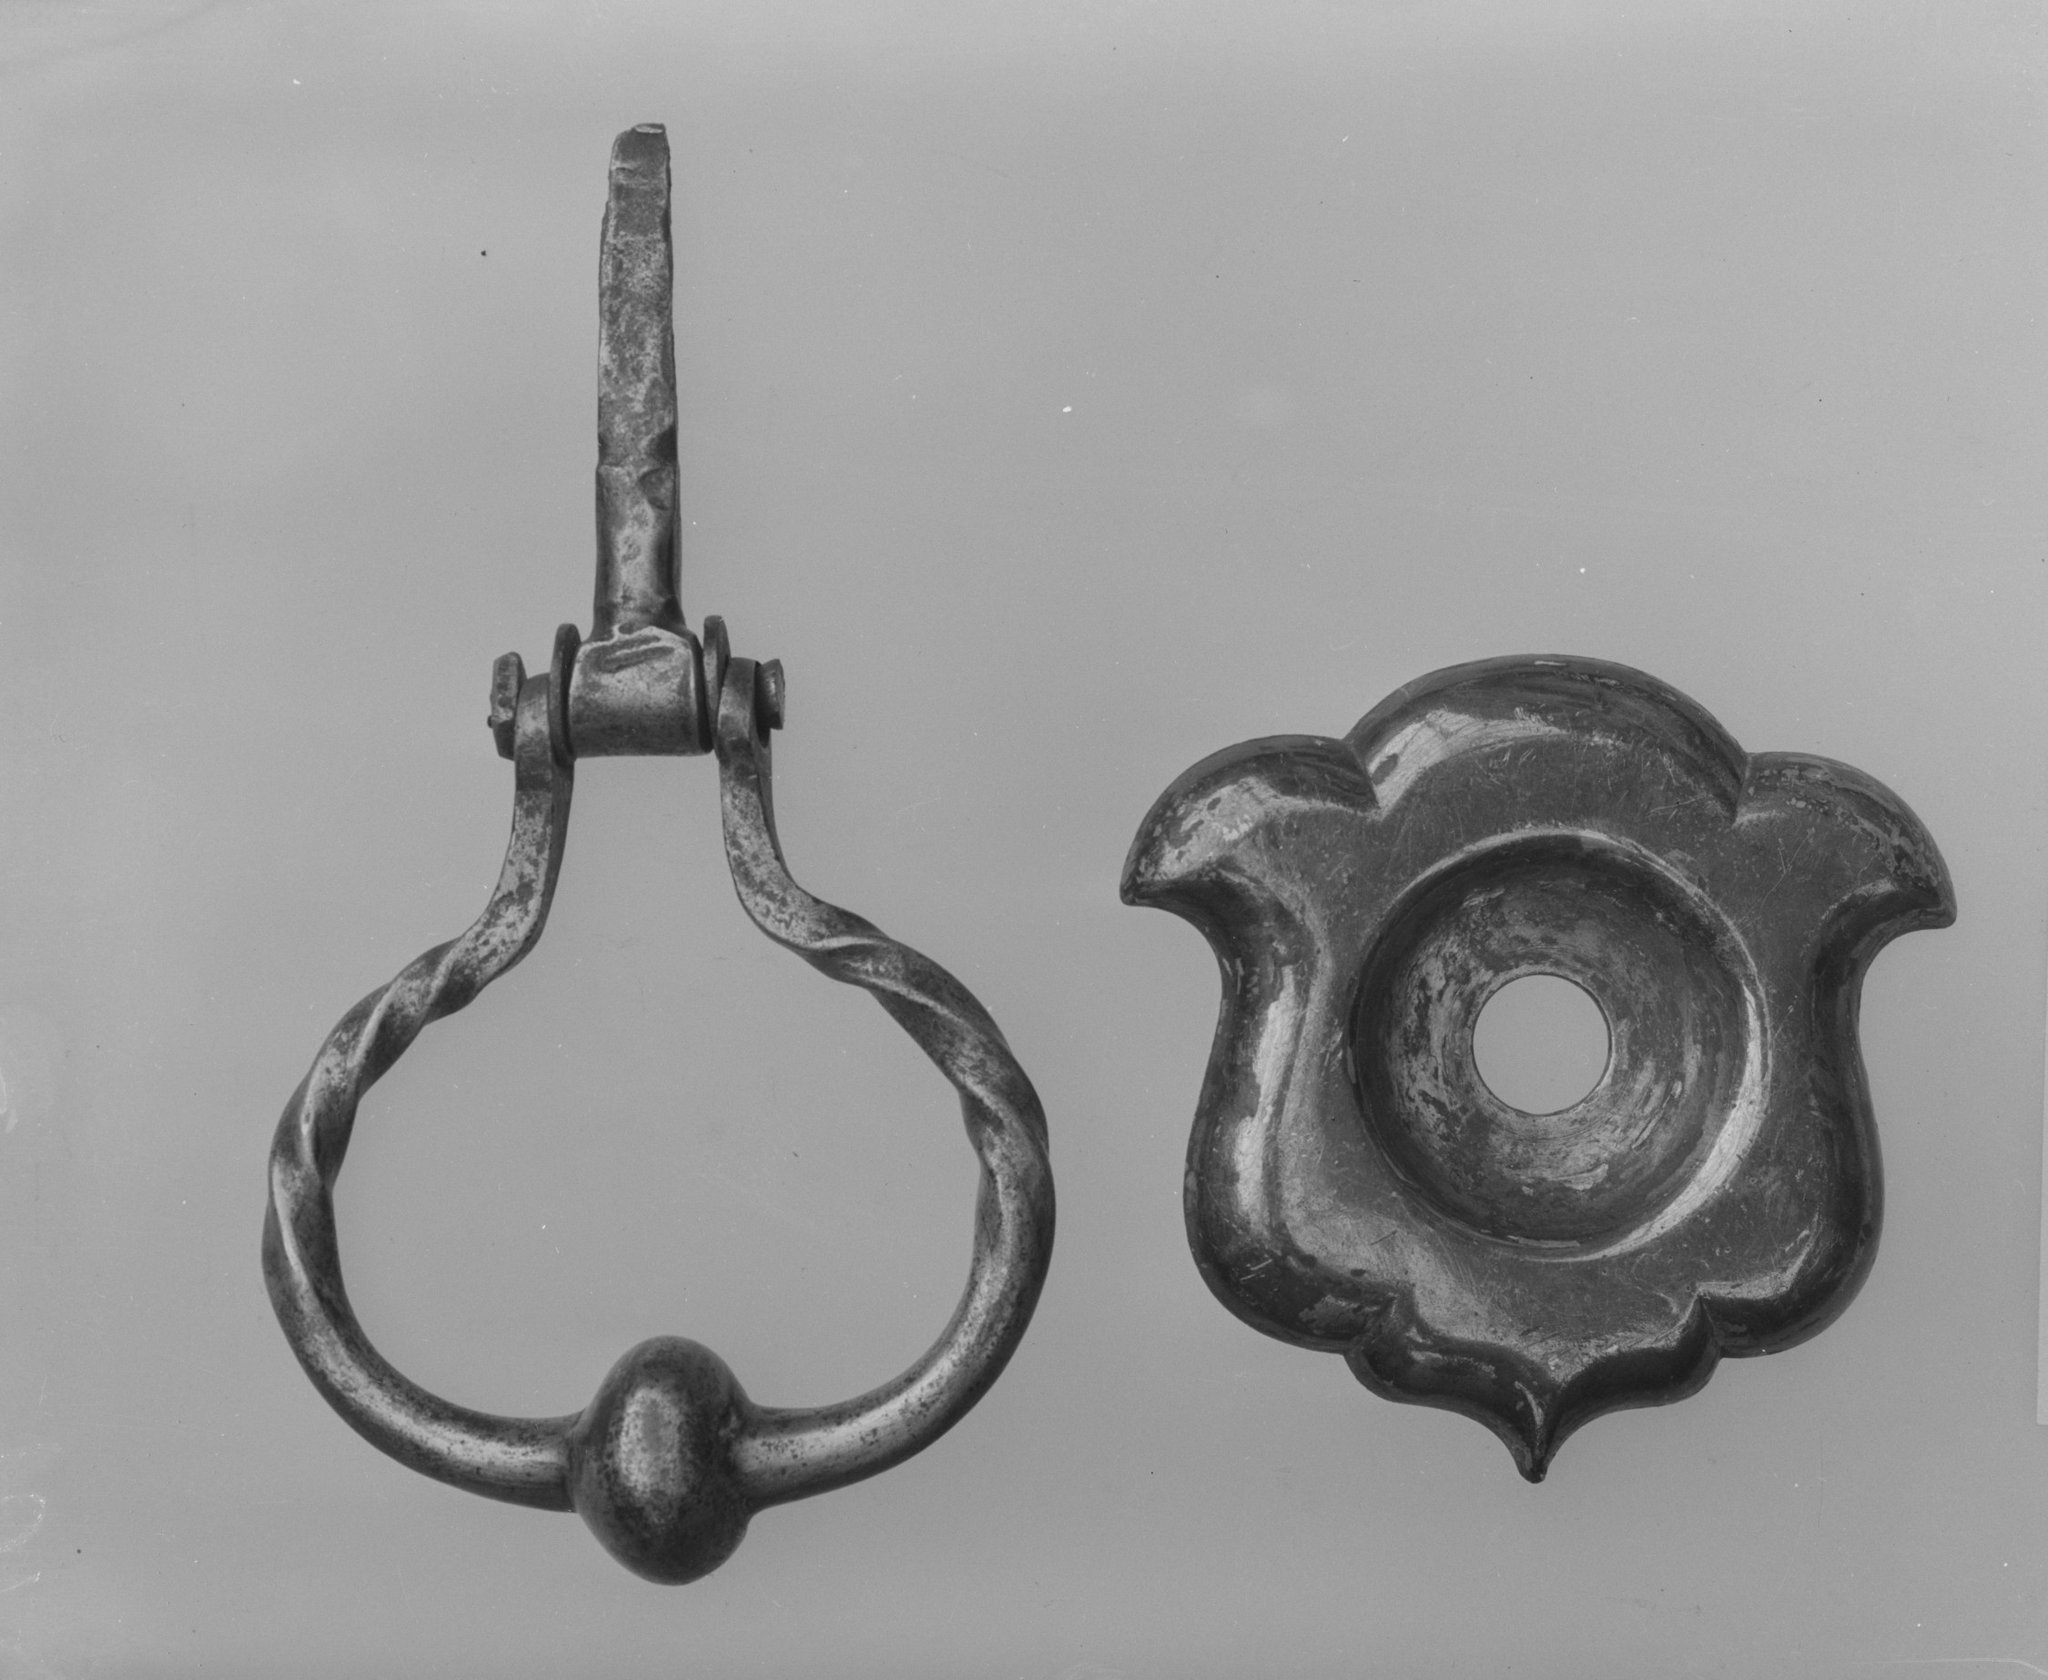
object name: knocker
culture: american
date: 1730-1770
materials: brass, iron, silver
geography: united states